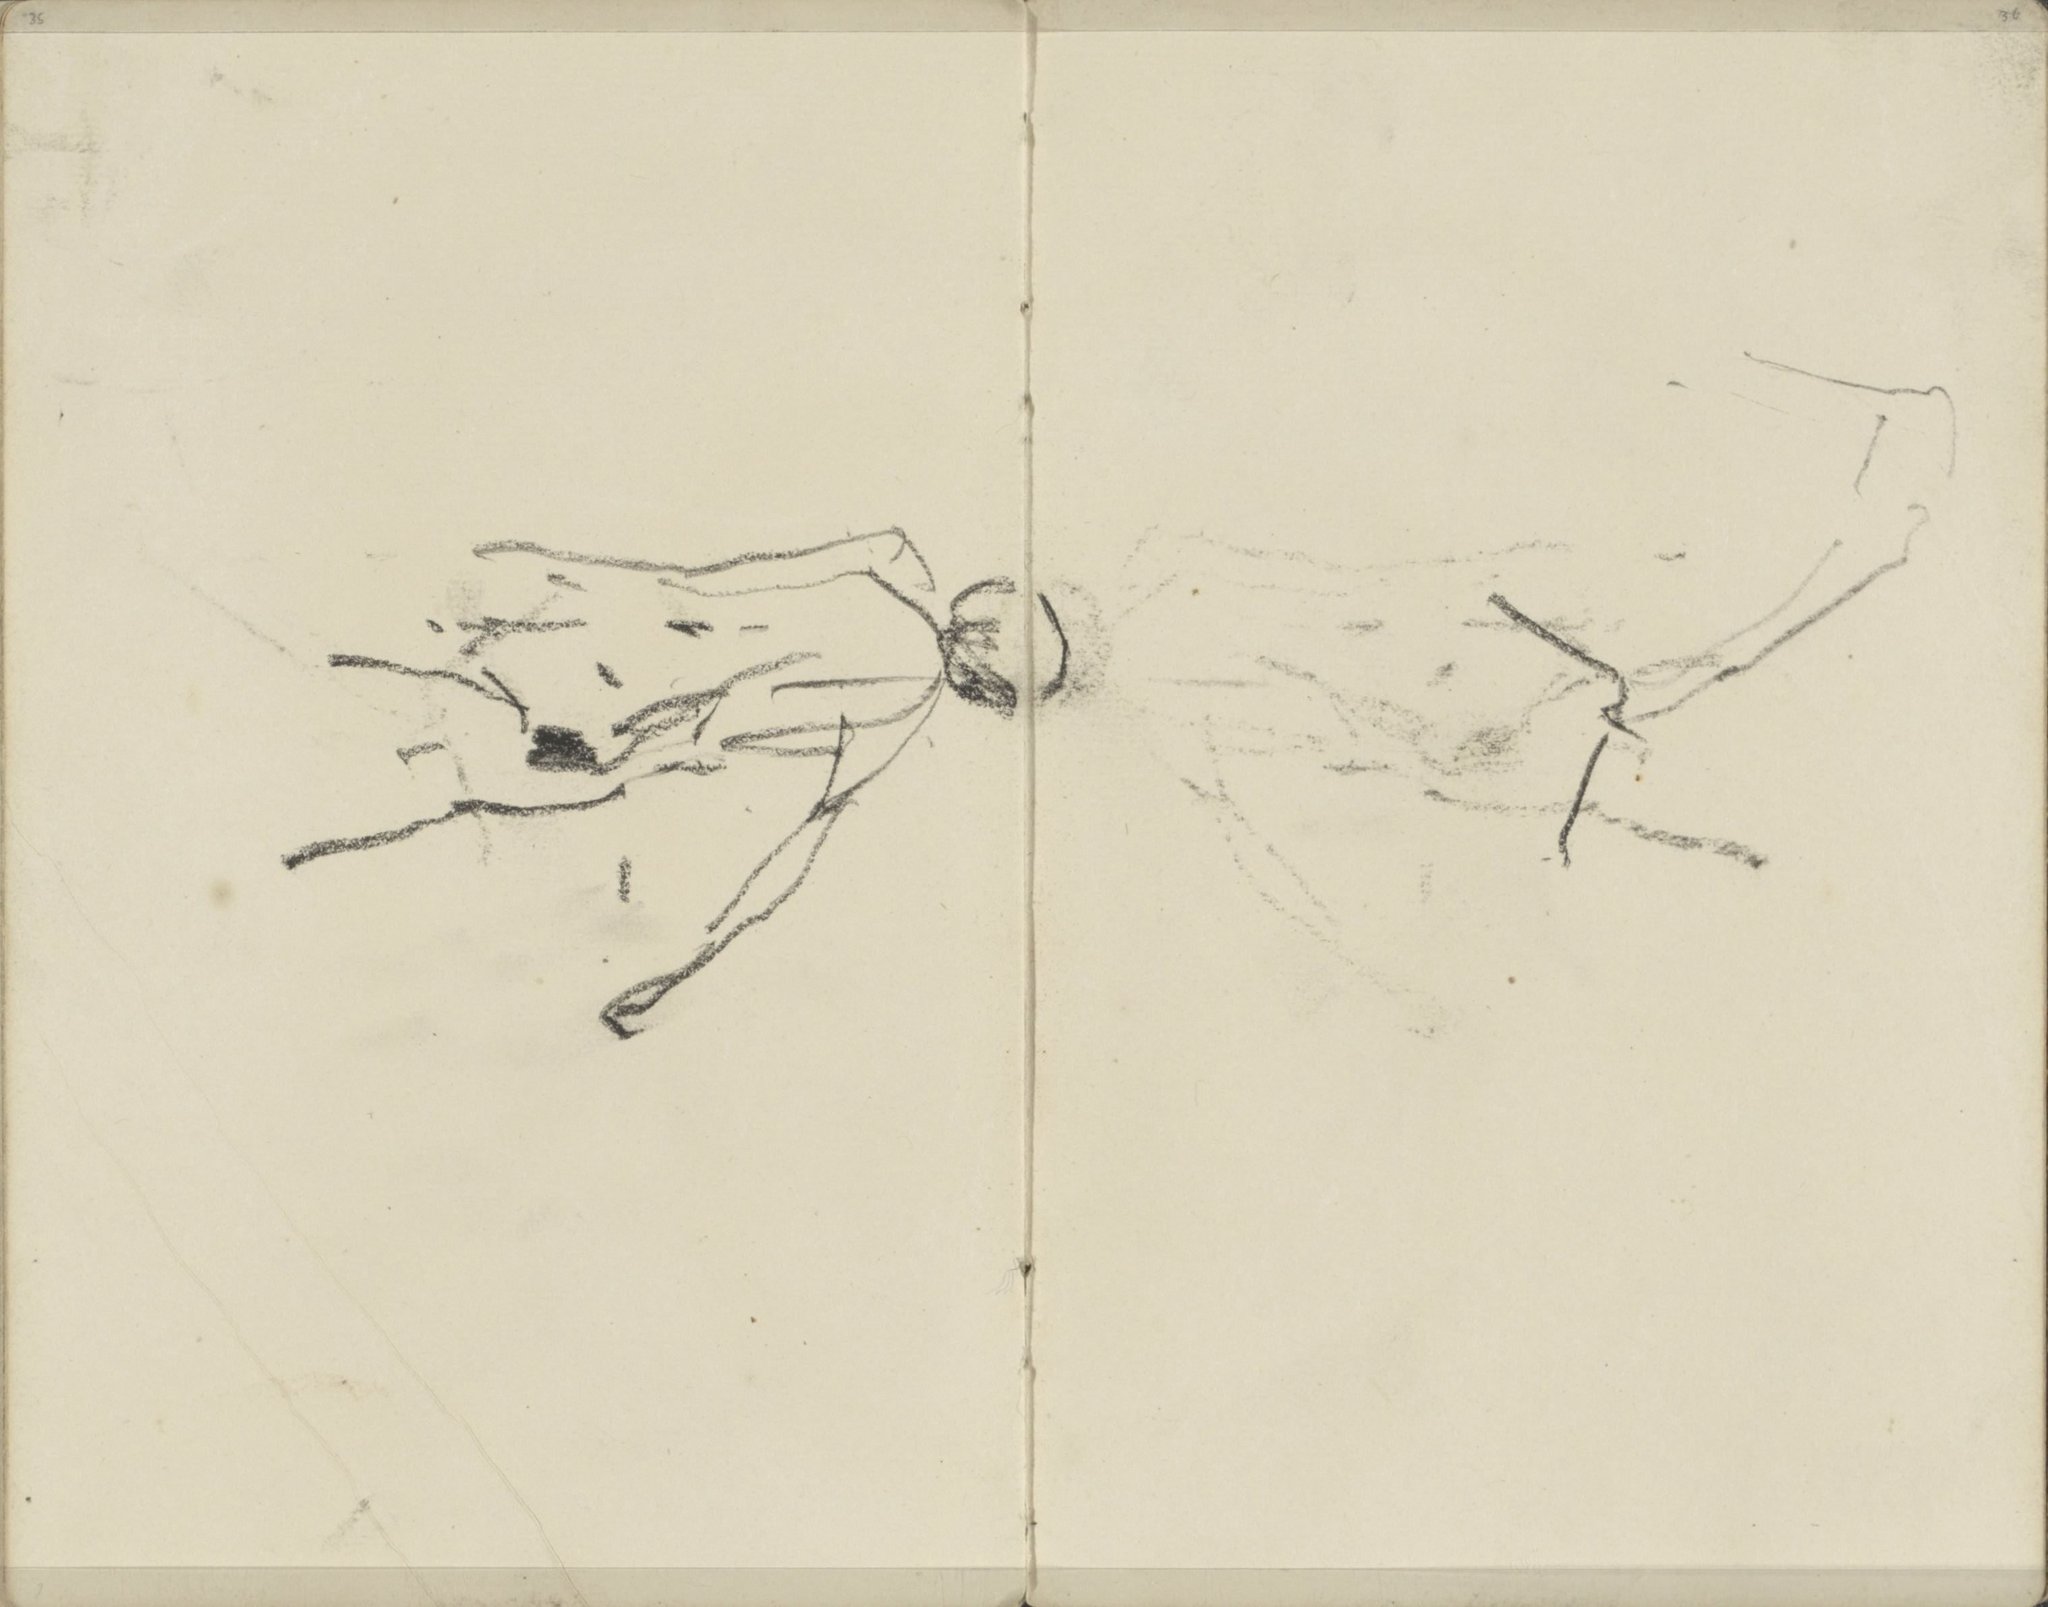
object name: sketchbook leaf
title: Figuurstudie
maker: george hendrik breitner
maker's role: draughtsman, painter, print maker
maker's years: 1857-1923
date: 1884-1886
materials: chalk, paper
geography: the hague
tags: adult woman (+ back view), adult man (+ back view)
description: Mogelijk een naakte figuur, op de rug gezien. Pagina 35 en pagina 36 uit een schetsboek met 19 bladen.